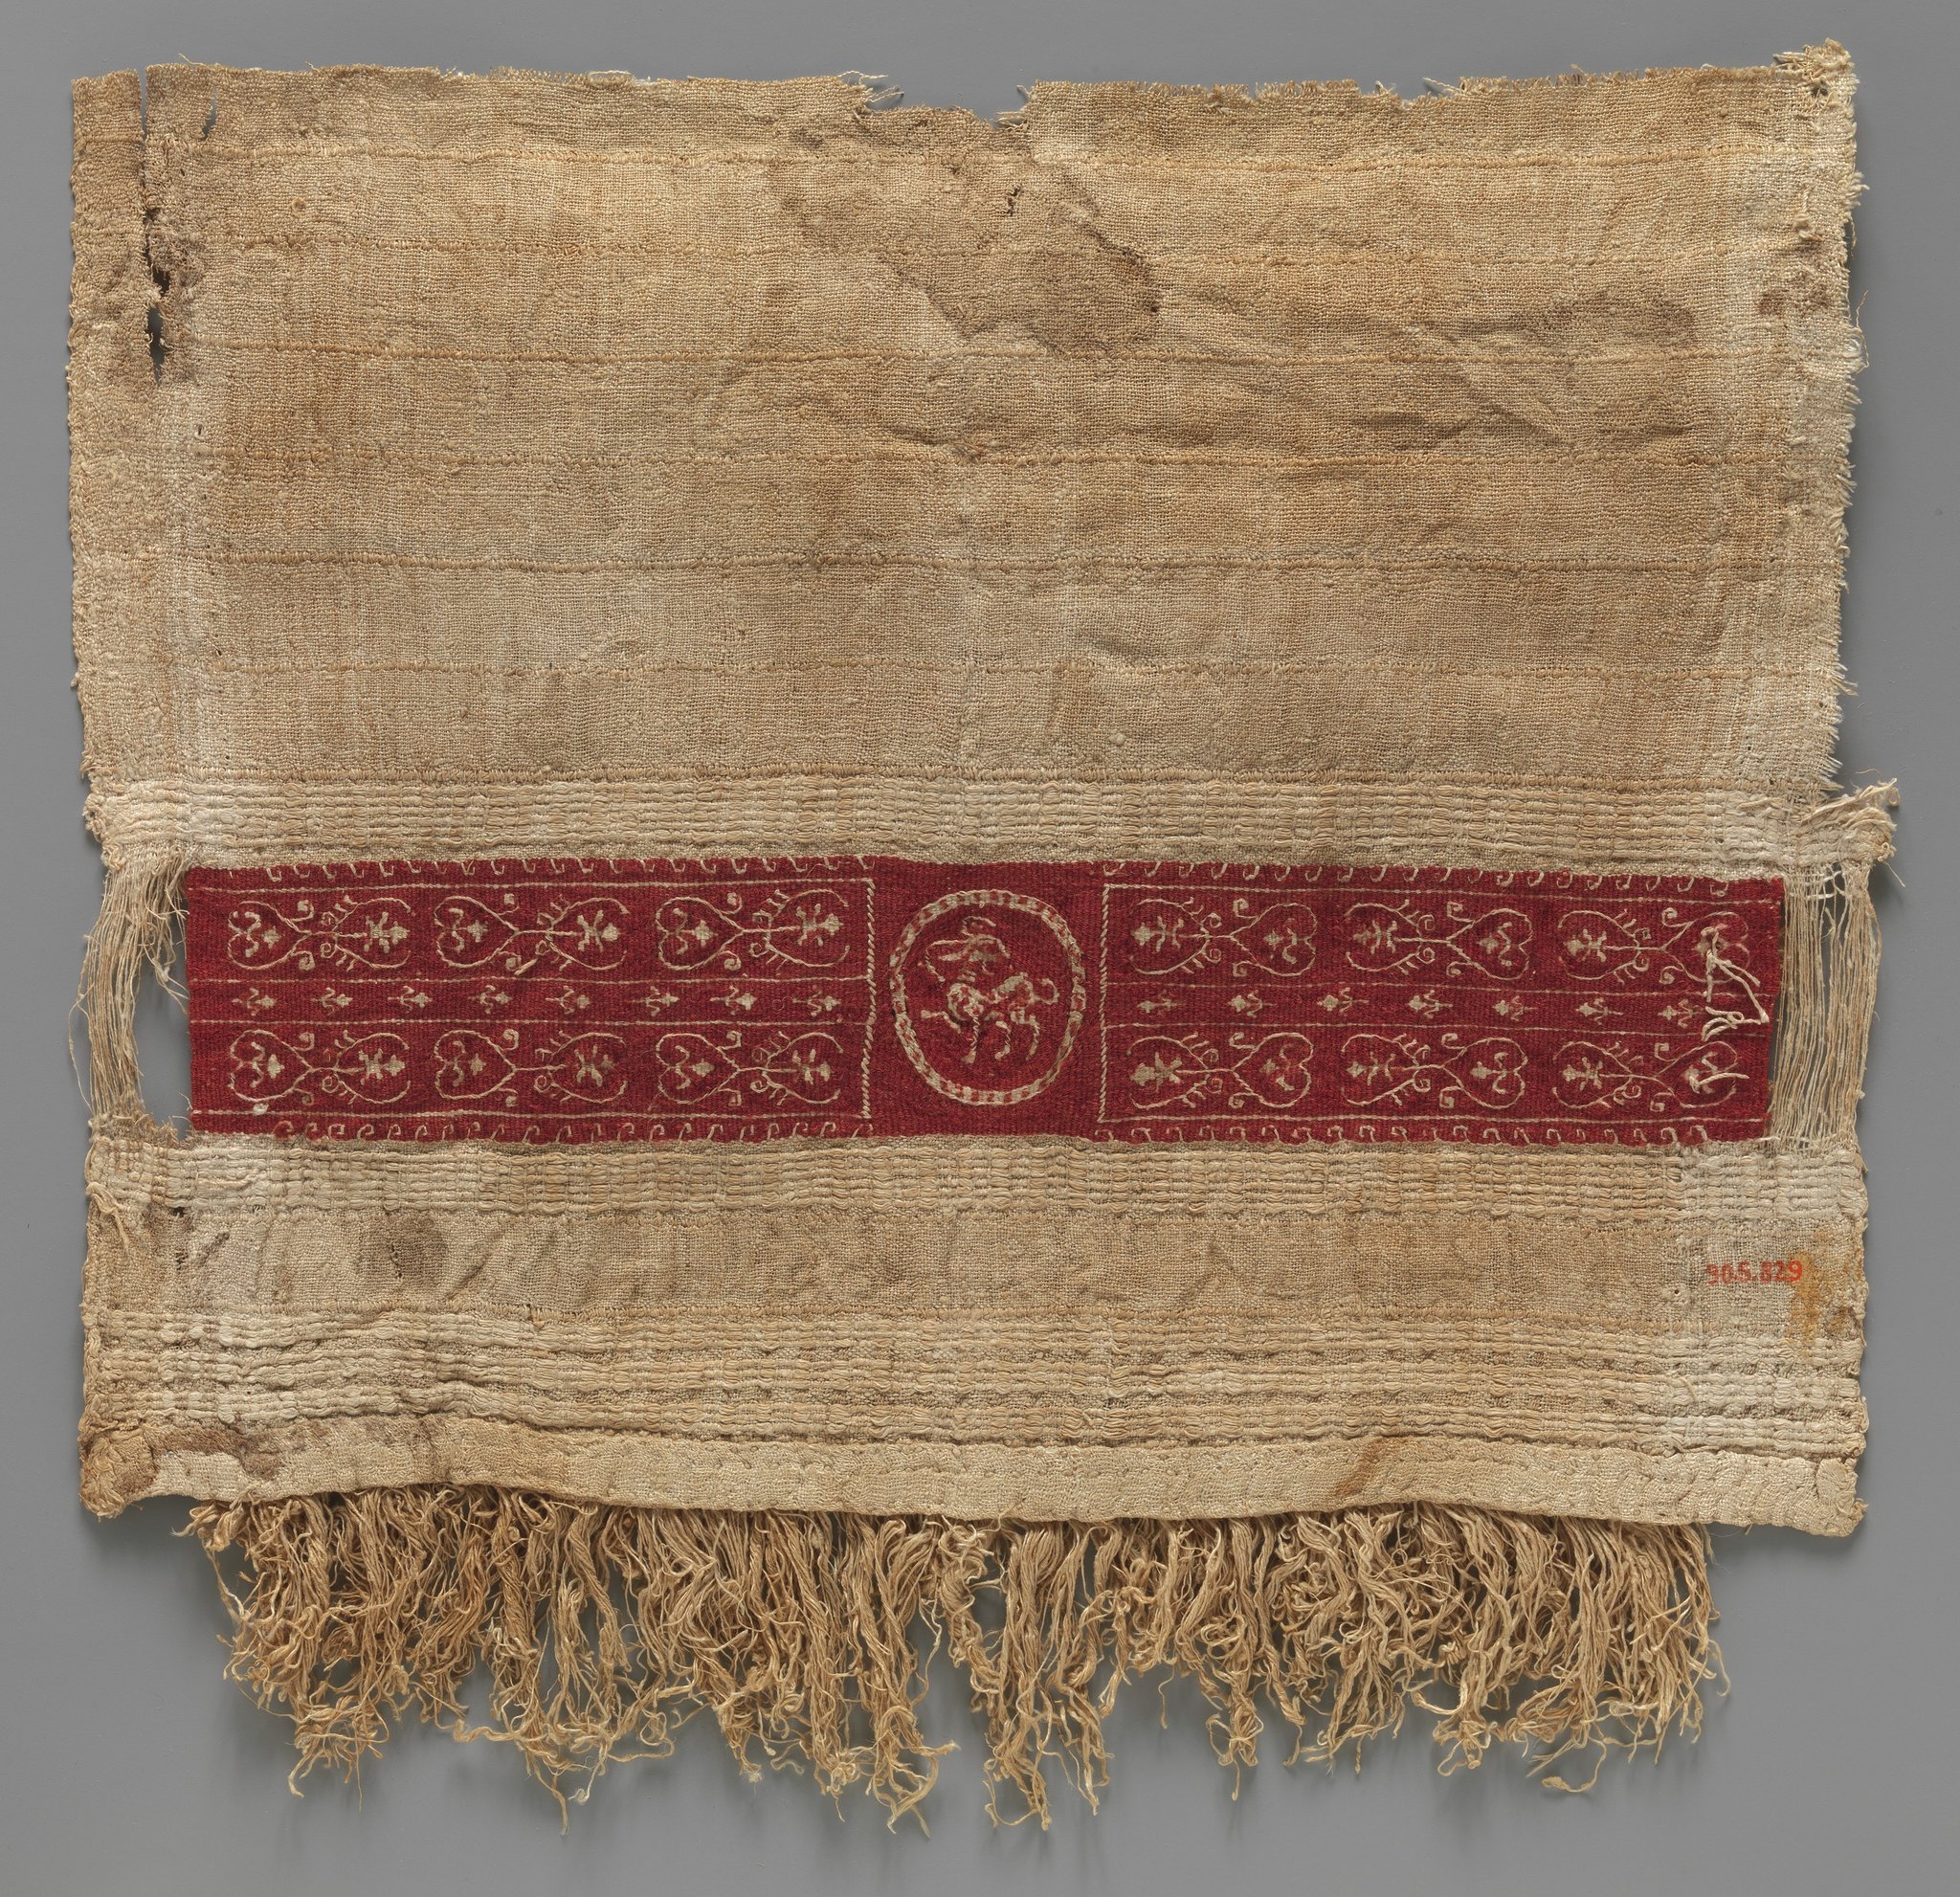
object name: fragment of a sleeve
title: Sleeve Fragment with a Band Decorated with an Animal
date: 801-1000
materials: linen, wool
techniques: dyeing, weave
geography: egypt